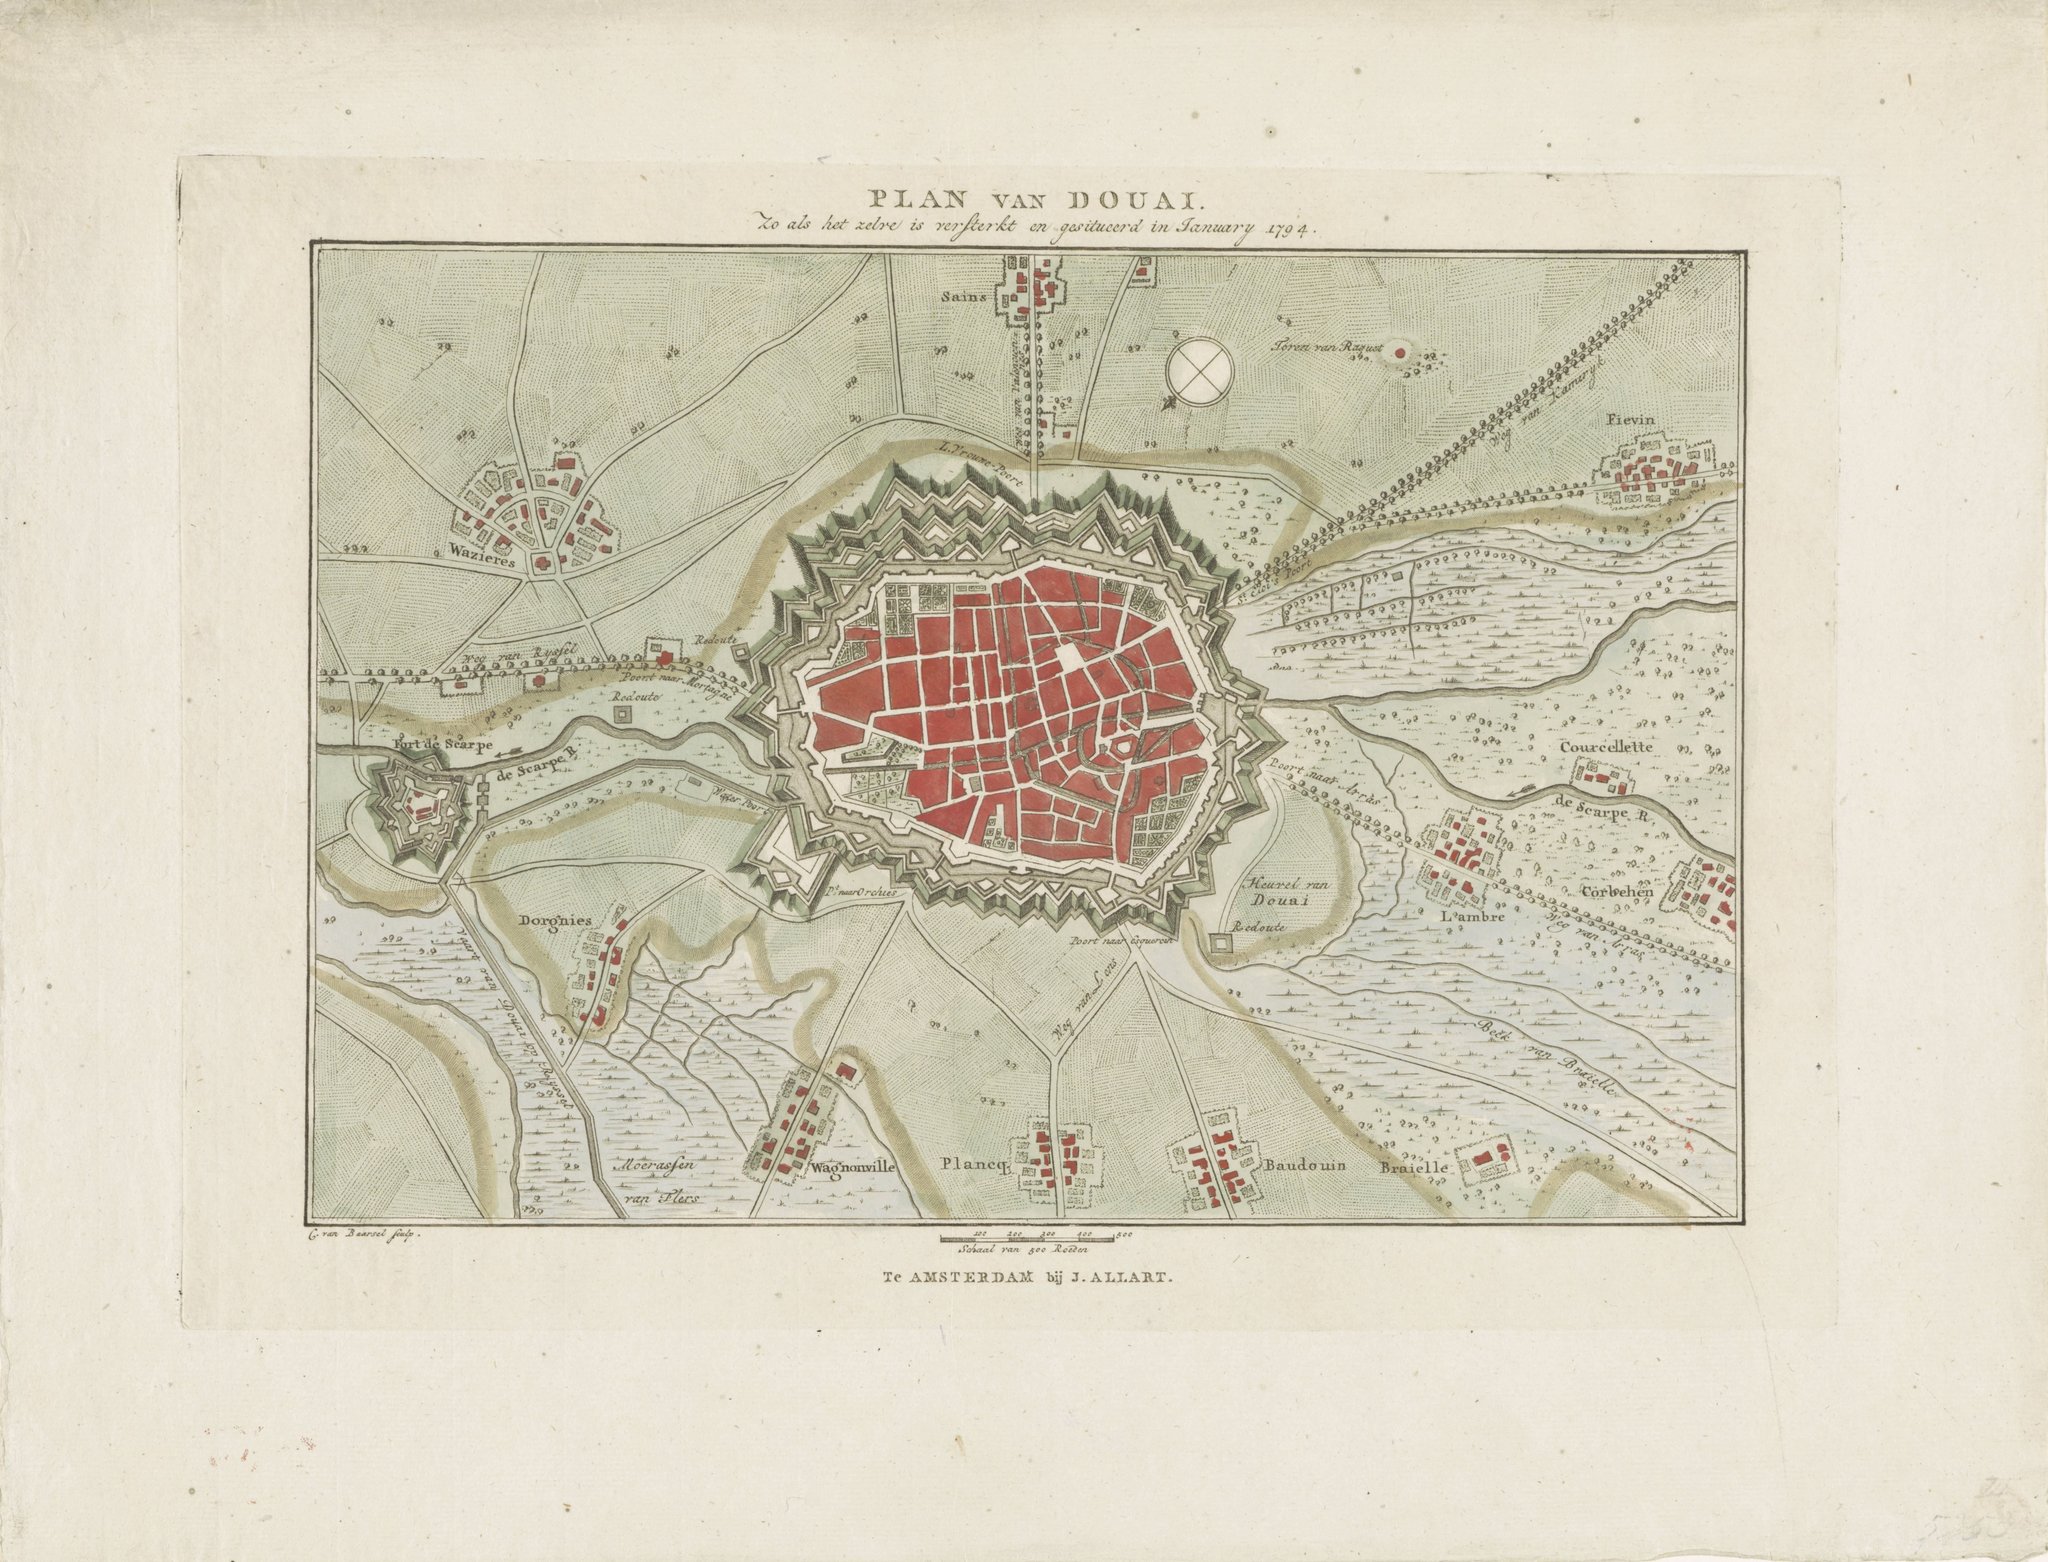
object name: map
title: Plan van Douai, zo als het zelve is versterkt en gesitueerd in January 1794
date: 1794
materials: paper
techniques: engraving, etching, hand coloring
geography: amsterdam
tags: fortified city, maps of cities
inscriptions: collector's mark: Lugt 2228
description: Plattegrond van de versterkingen om de stad Douai, in januari 1794. Onderdeel van een serie van zeven bladen met plattegronden van versterkte steden in de Oostenrijkse Nederlanden ten tijde van de tweede Franse inval onder generaal Pichu in 1794.